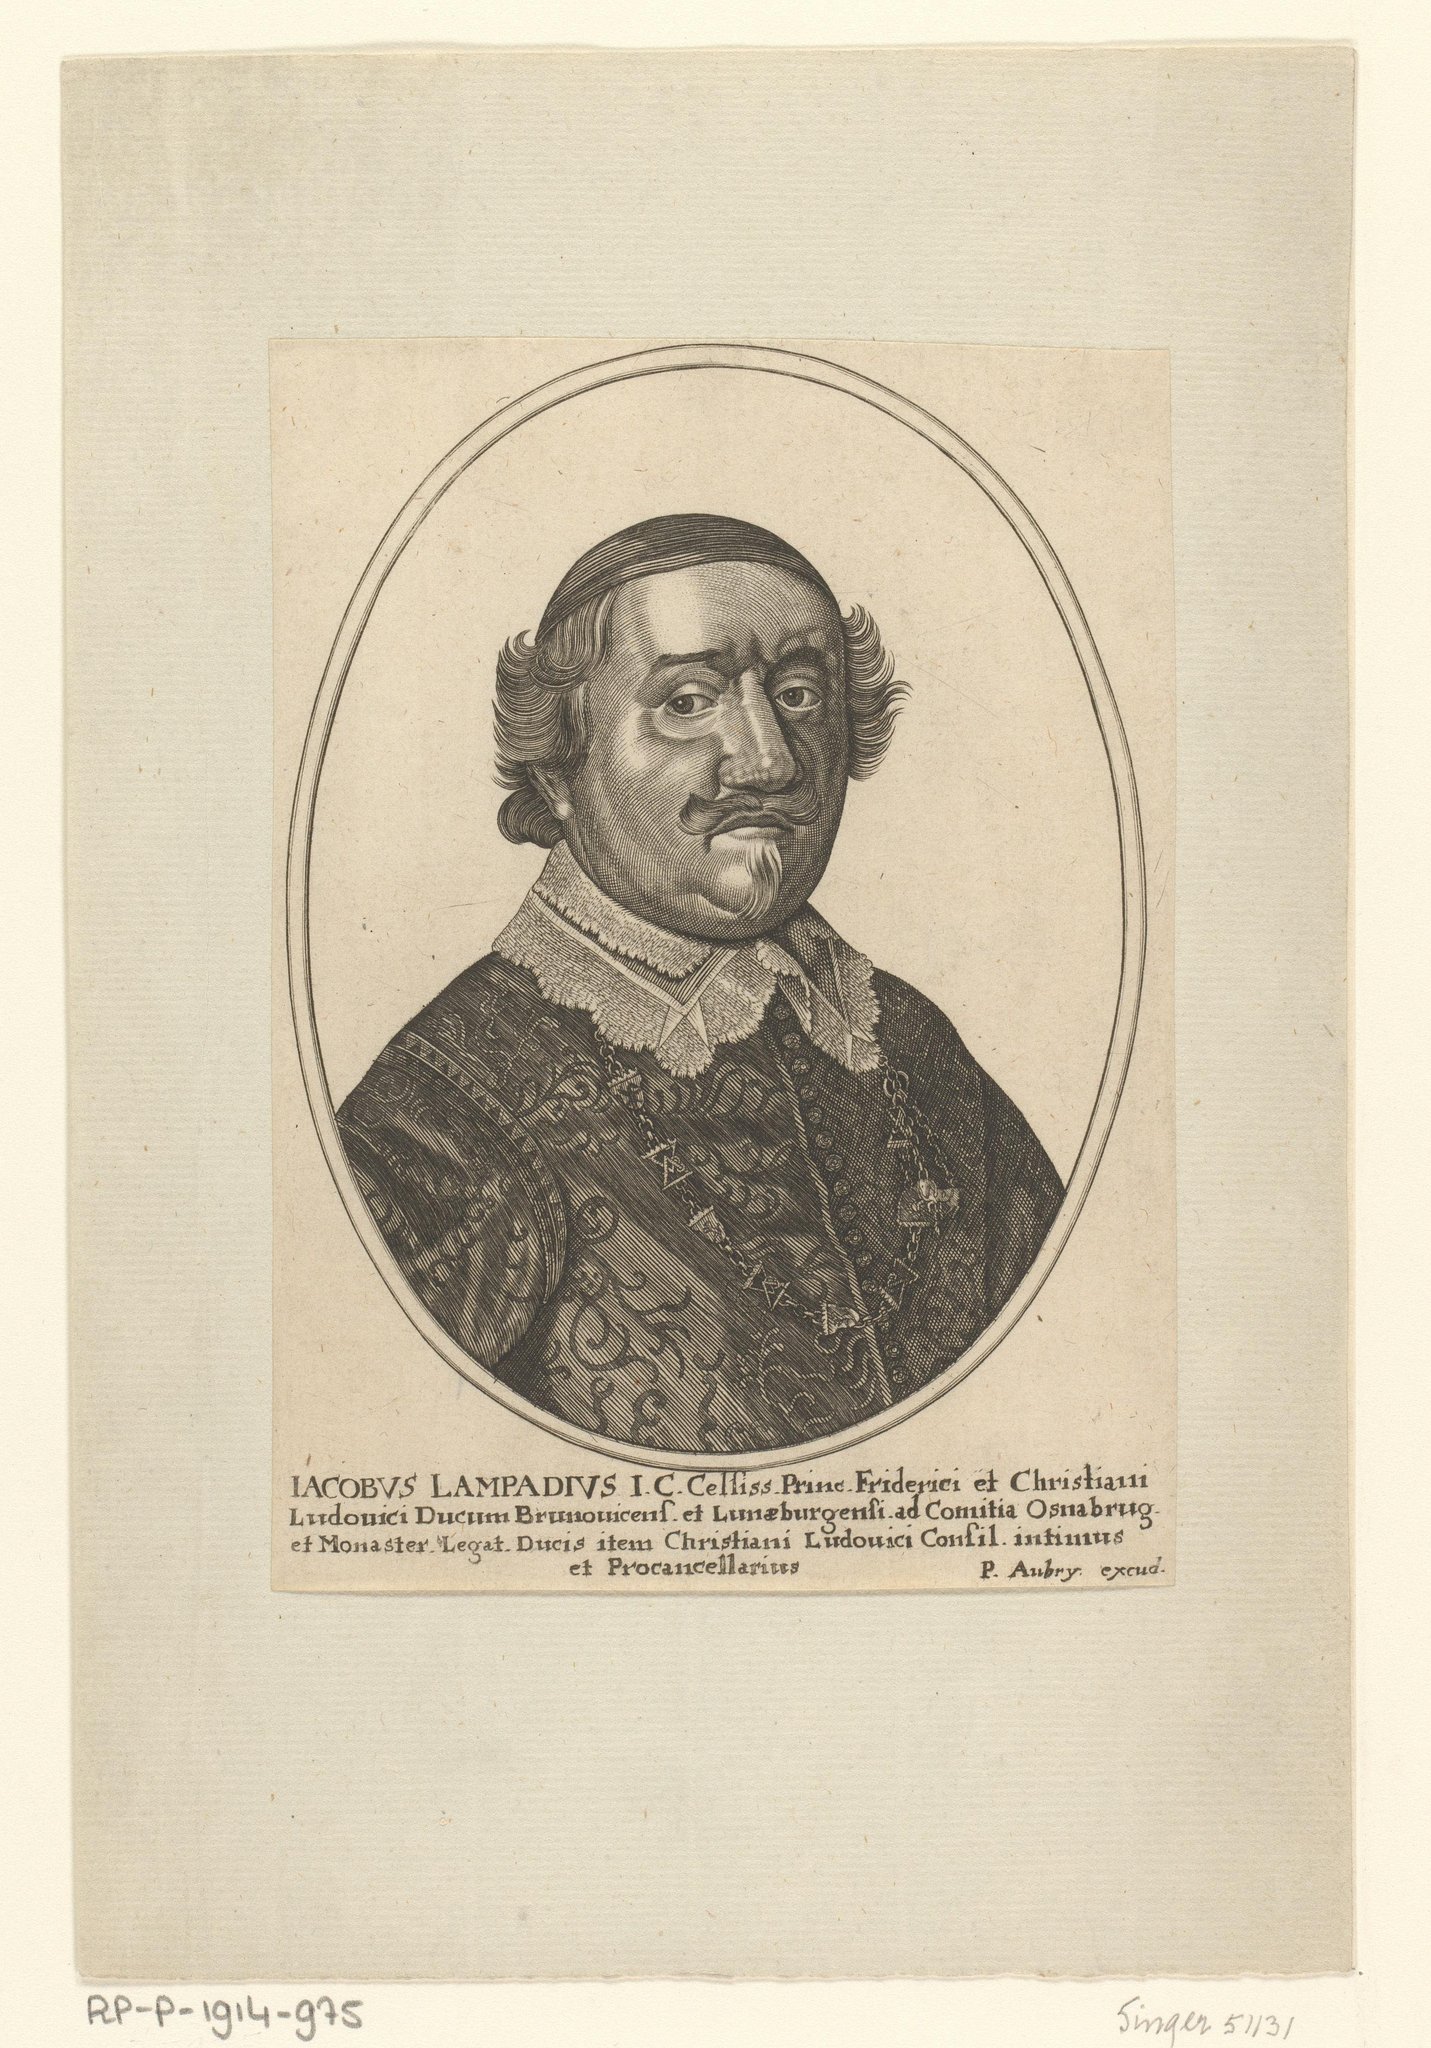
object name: print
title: Portret van Jakob Lampadius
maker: Anonymous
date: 1643-1686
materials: paper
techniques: engraving, snipping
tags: historical persons, lawyer, attorney at law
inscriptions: collector's mark: Lugt 2228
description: Met vierregelig onderschrift in het Latijn.